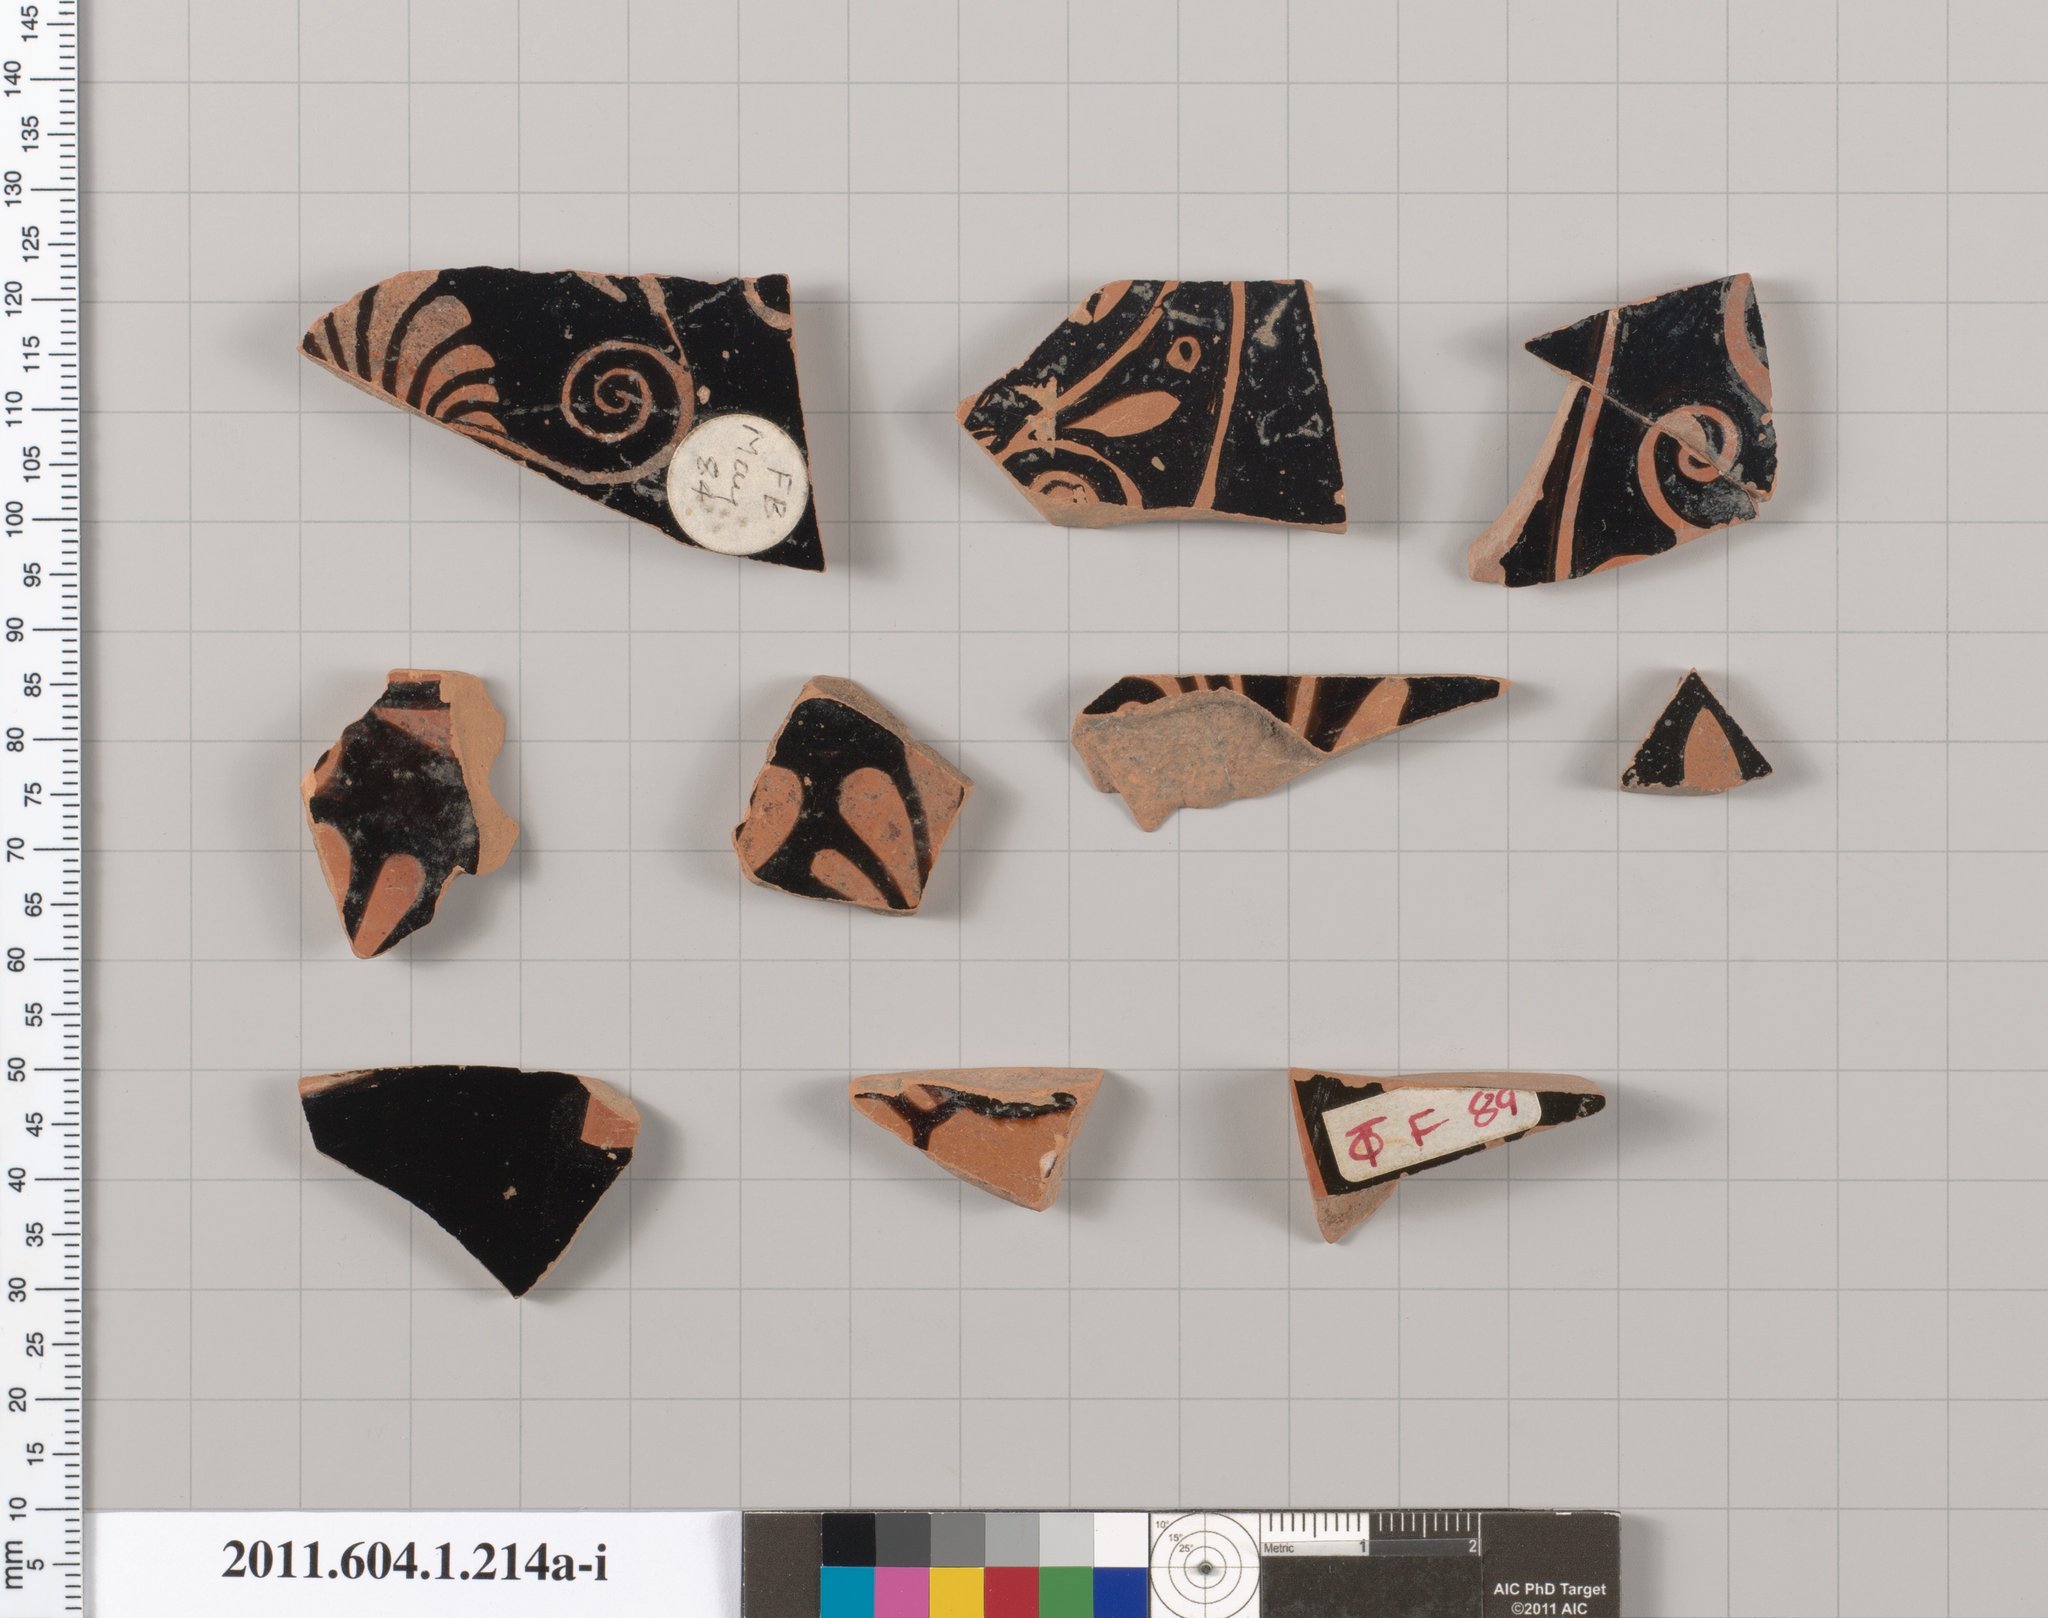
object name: kylix fragment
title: Terracotta fragments of a kylix (drinking cup)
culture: greek, attic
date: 475-451 BCE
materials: terracotta